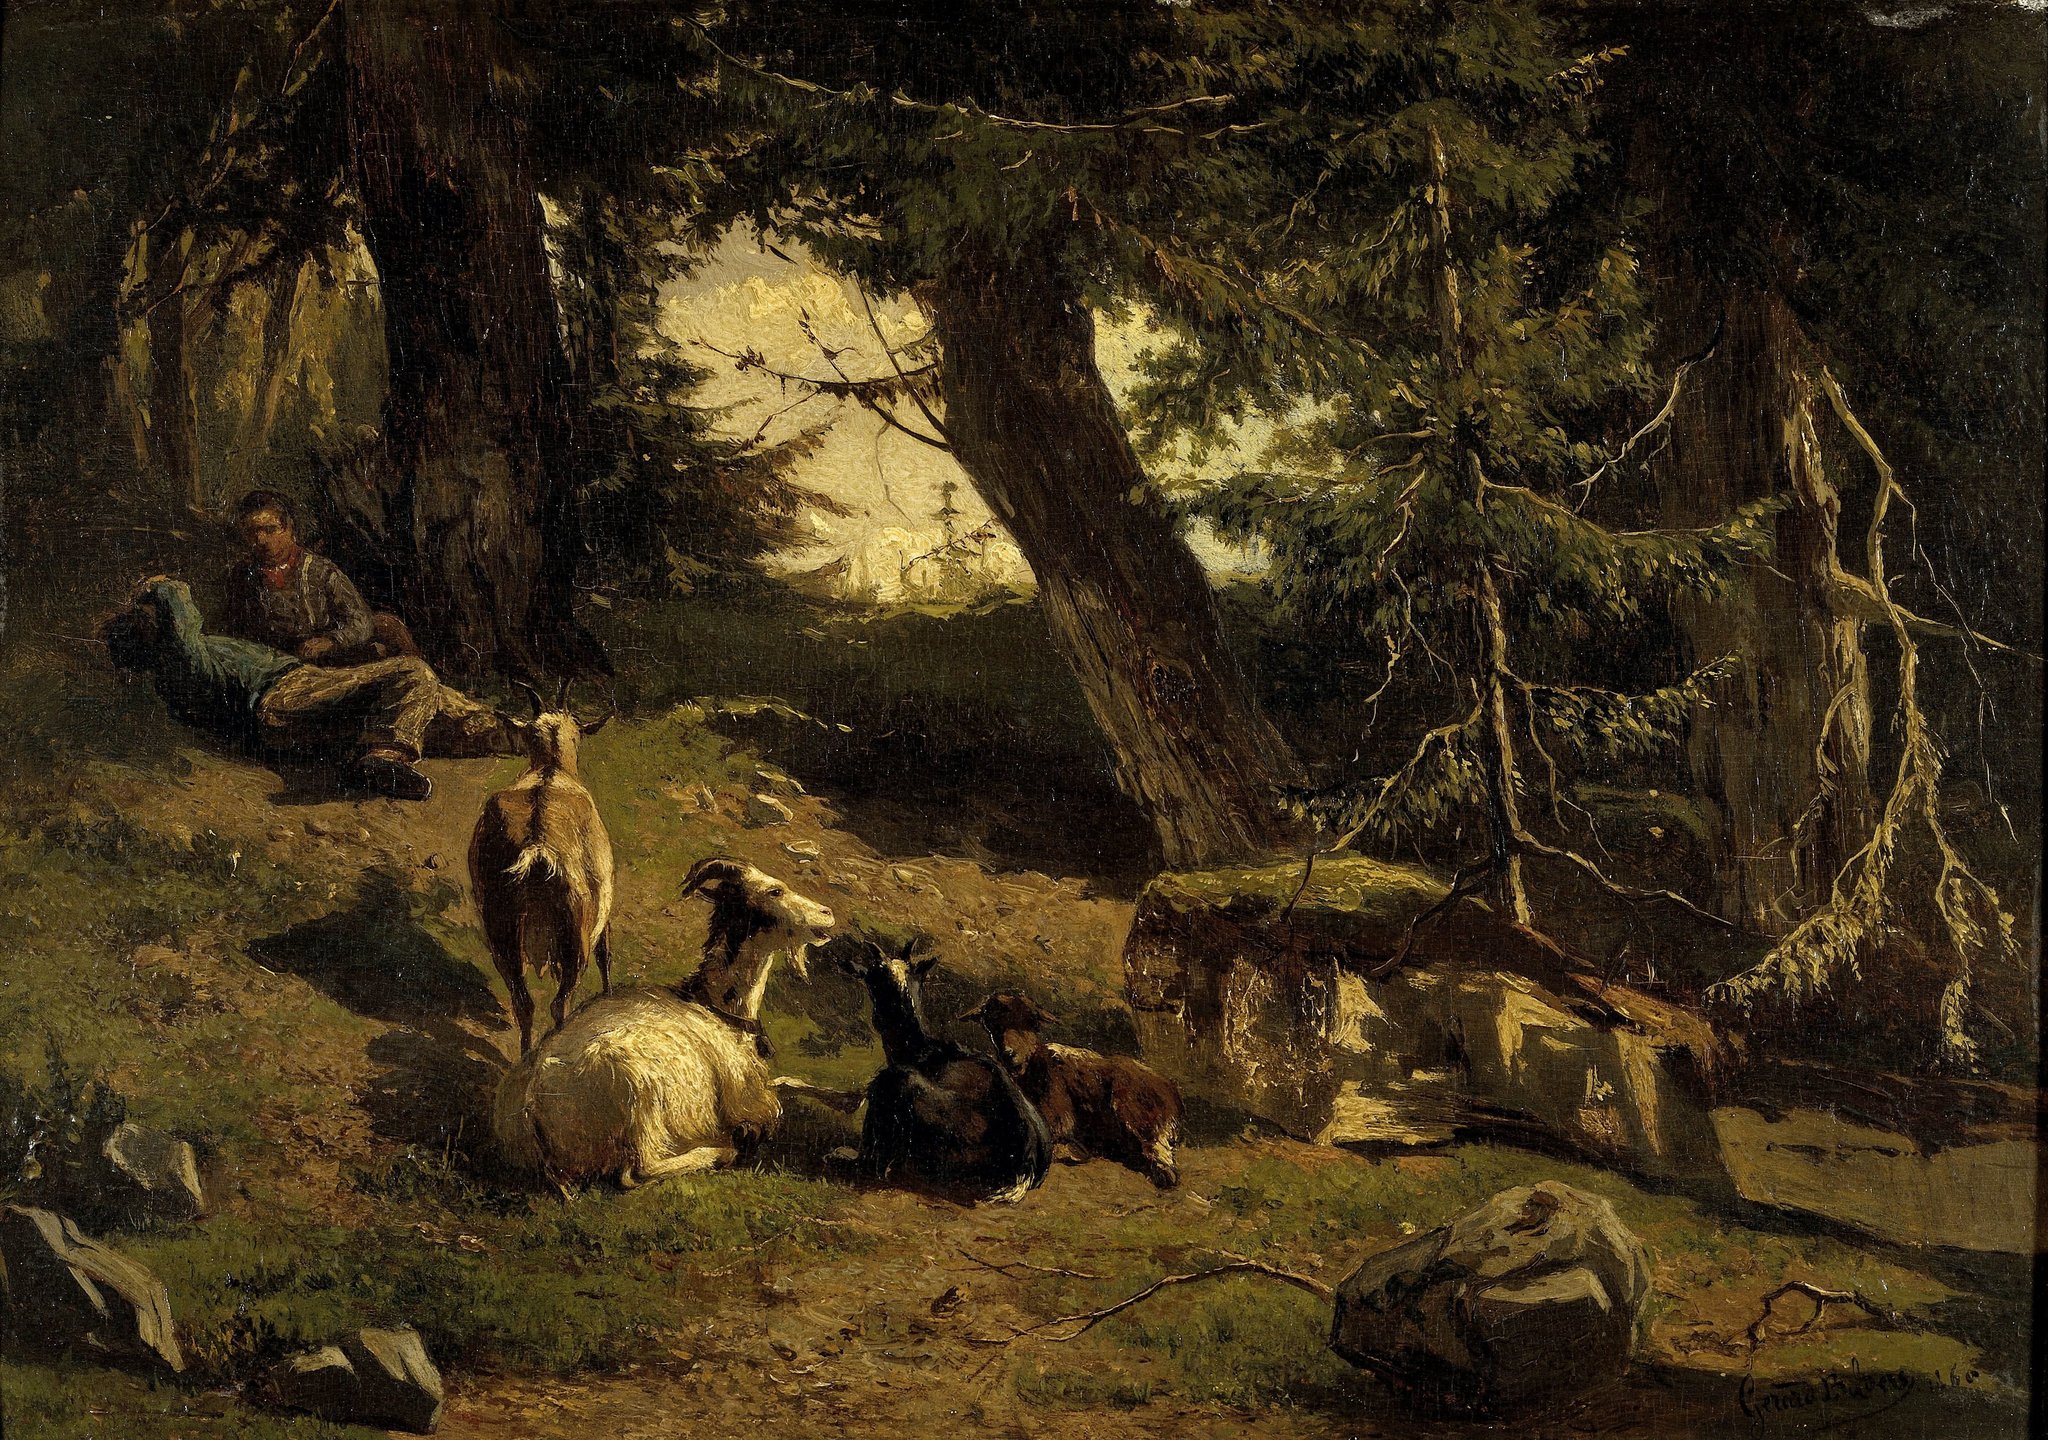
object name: painting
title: Swiss Landscape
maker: gerard bilders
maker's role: draughtsman, print maker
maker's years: 1838-1865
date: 1860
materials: oil, panel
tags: herding, herdsman, herdswoman, shepherd, shepherdess, cowherd, etc., forest, wood, goat, switzerland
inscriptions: signature and date: ‘Gerard Bilders 1860’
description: Landschap in Zwitserland. Twee geitenhoeders rusten in de schaduw van naaldbomen.